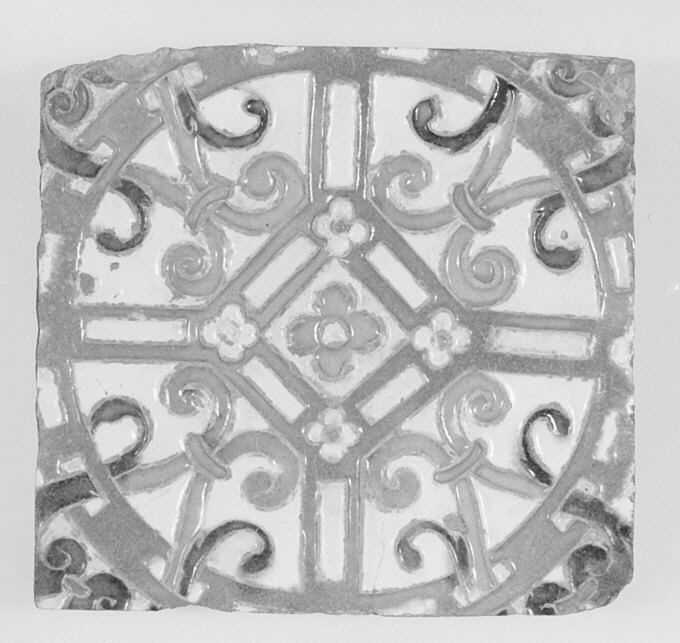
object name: wall tile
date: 1501-1600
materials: earthenware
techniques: glazing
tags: flowers